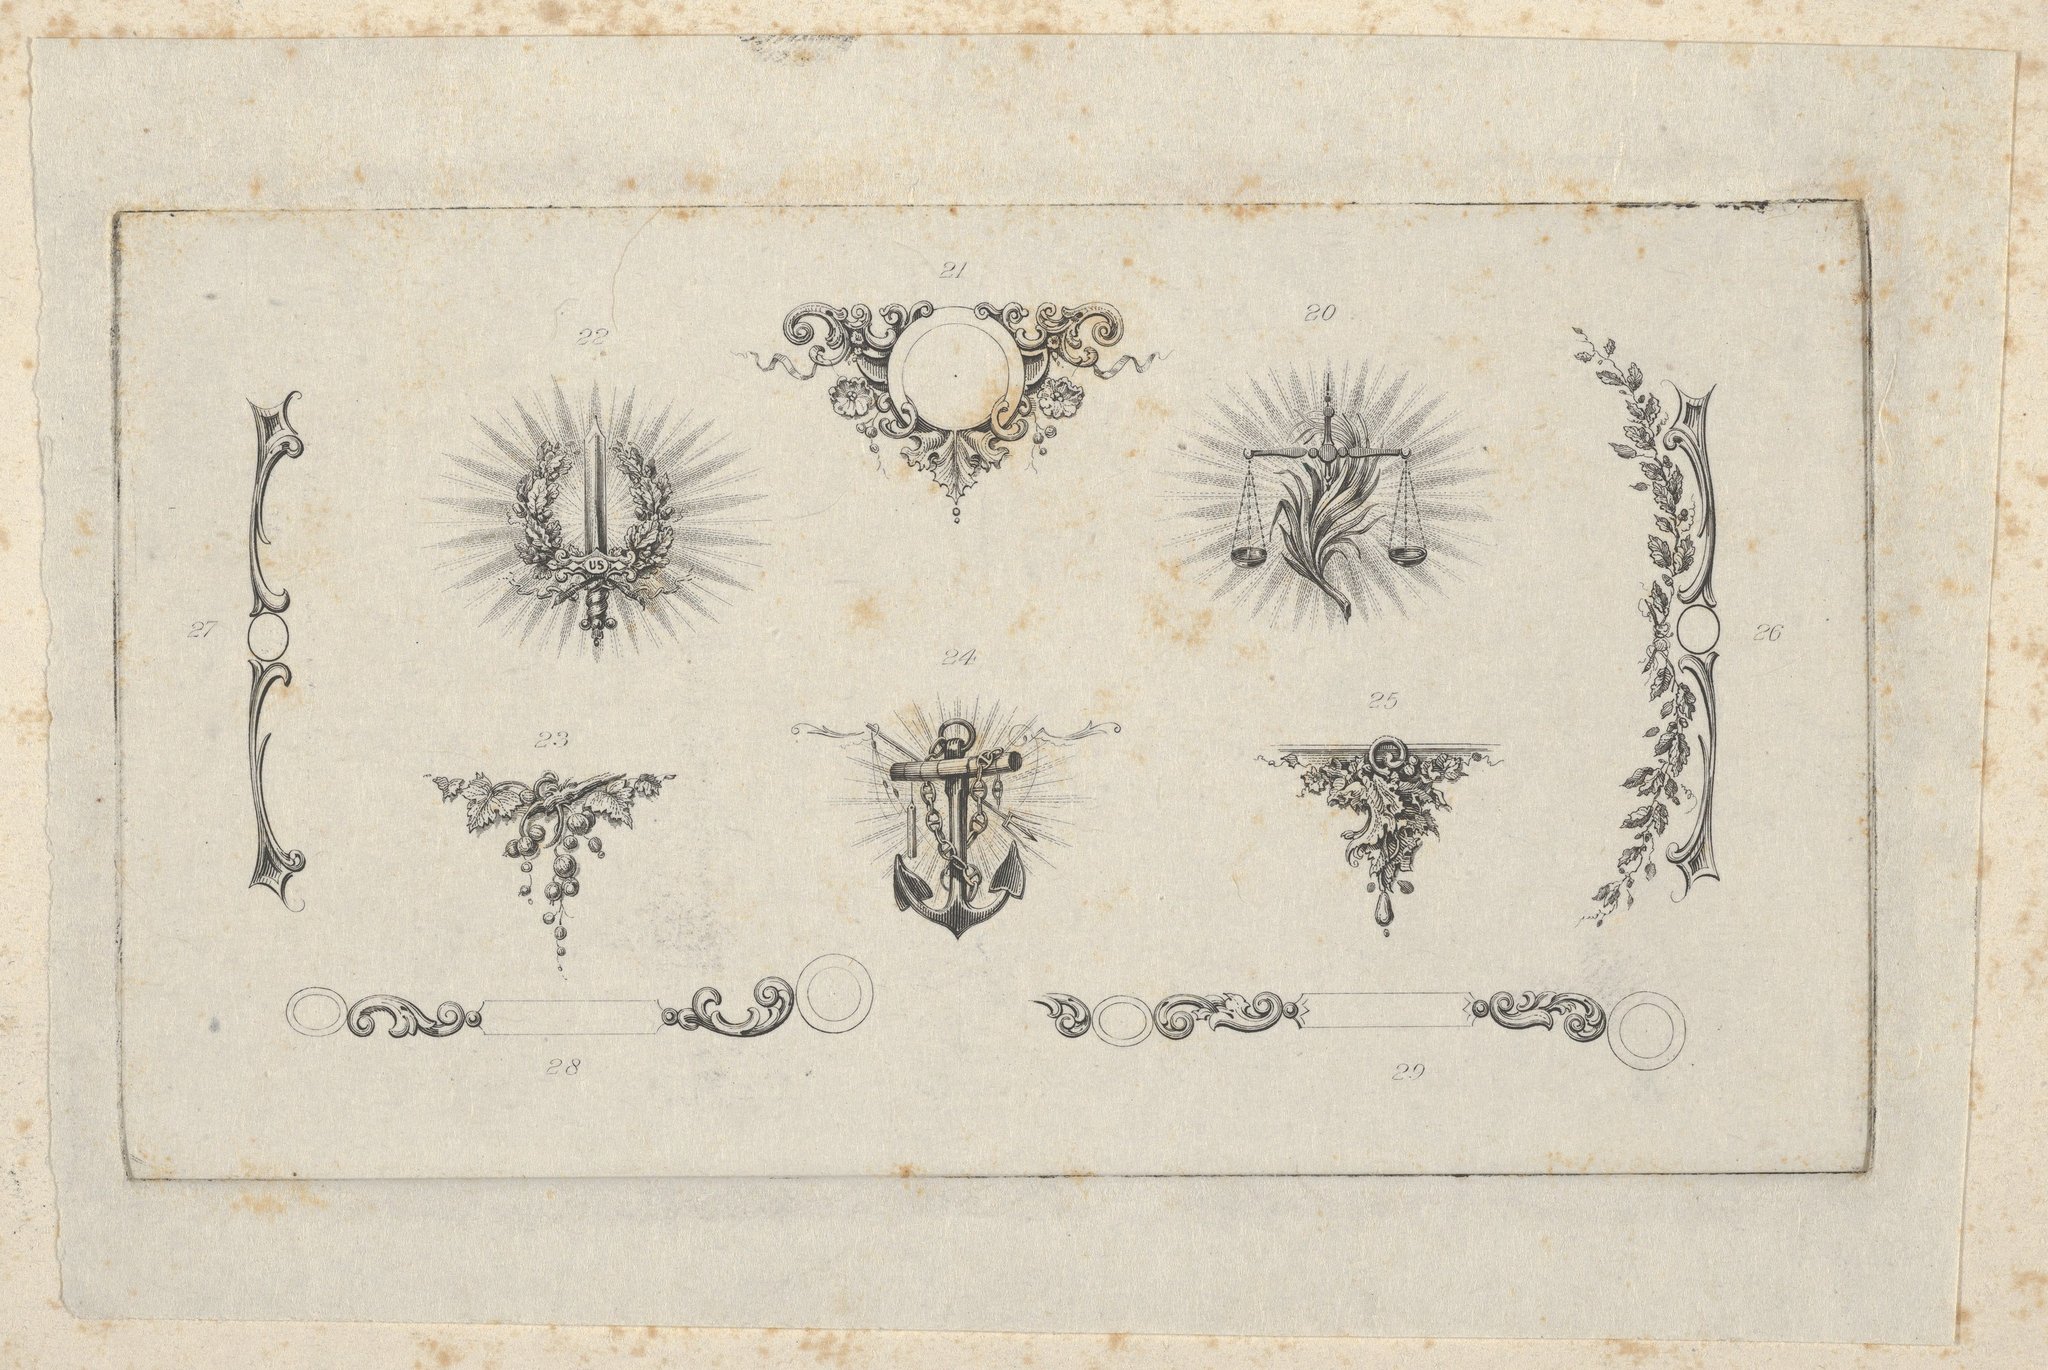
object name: print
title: Banknote motif: ten different ornamental lathe work elements including a disk embellished with berries and flowers, a wreathed sword, a set of scales, a berried vine, an anchor and chain, a bracket of vine leaves and four designs for borders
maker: cyrus durand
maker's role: artist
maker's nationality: american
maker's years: 1787-1868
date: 1824-1842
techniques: printmaking, engraving, etching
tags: swords,scales